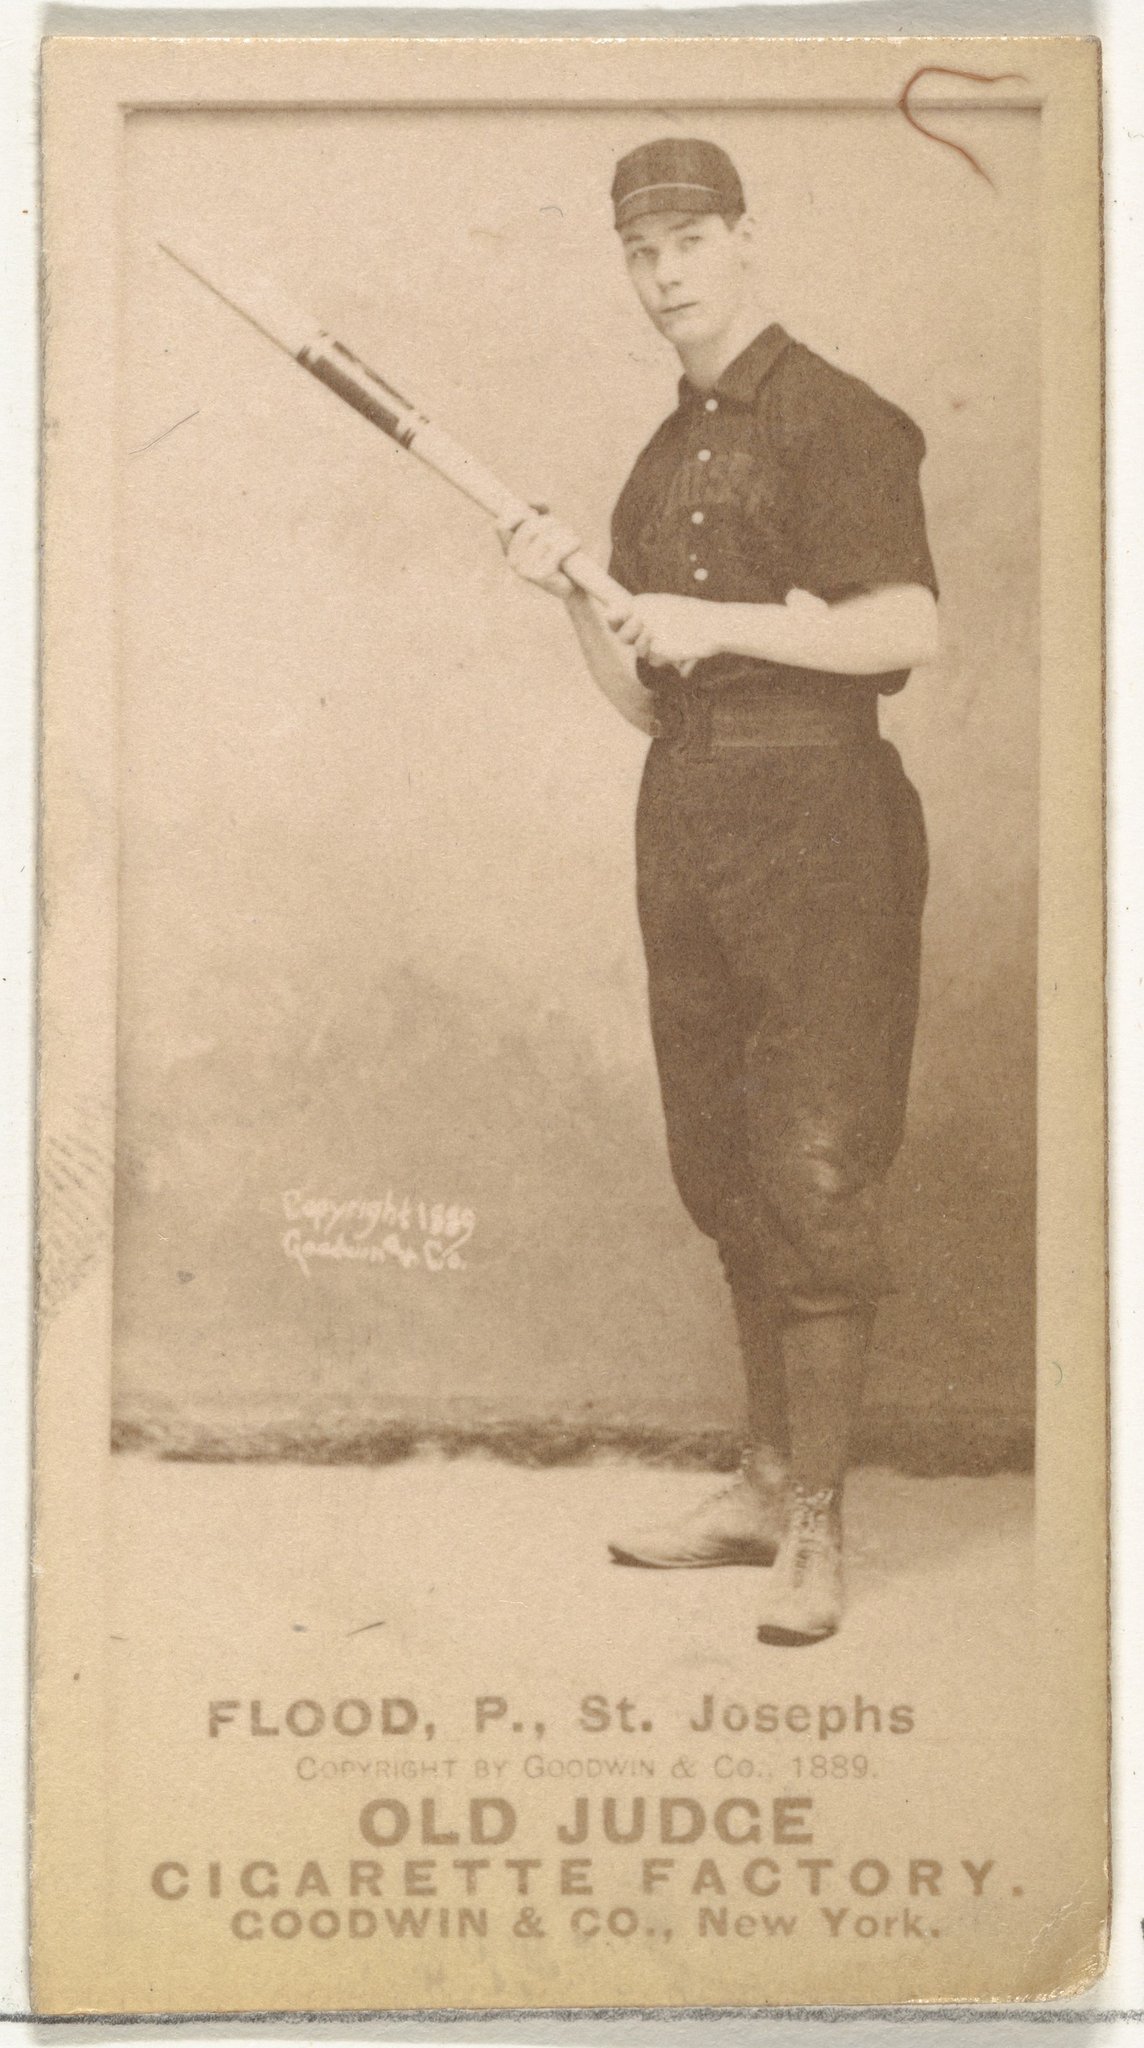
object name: baseball card, photograph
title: Thomas J. Flood, Pitcher, St. Joseph Clay Eaters, from the Old Judge series (N172) for Old Judge Cigarettes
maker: goodwin & company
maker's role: publisher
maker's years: 1850-1950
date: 1889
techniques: albumen silver print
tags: men,portraits,baseball,athletes